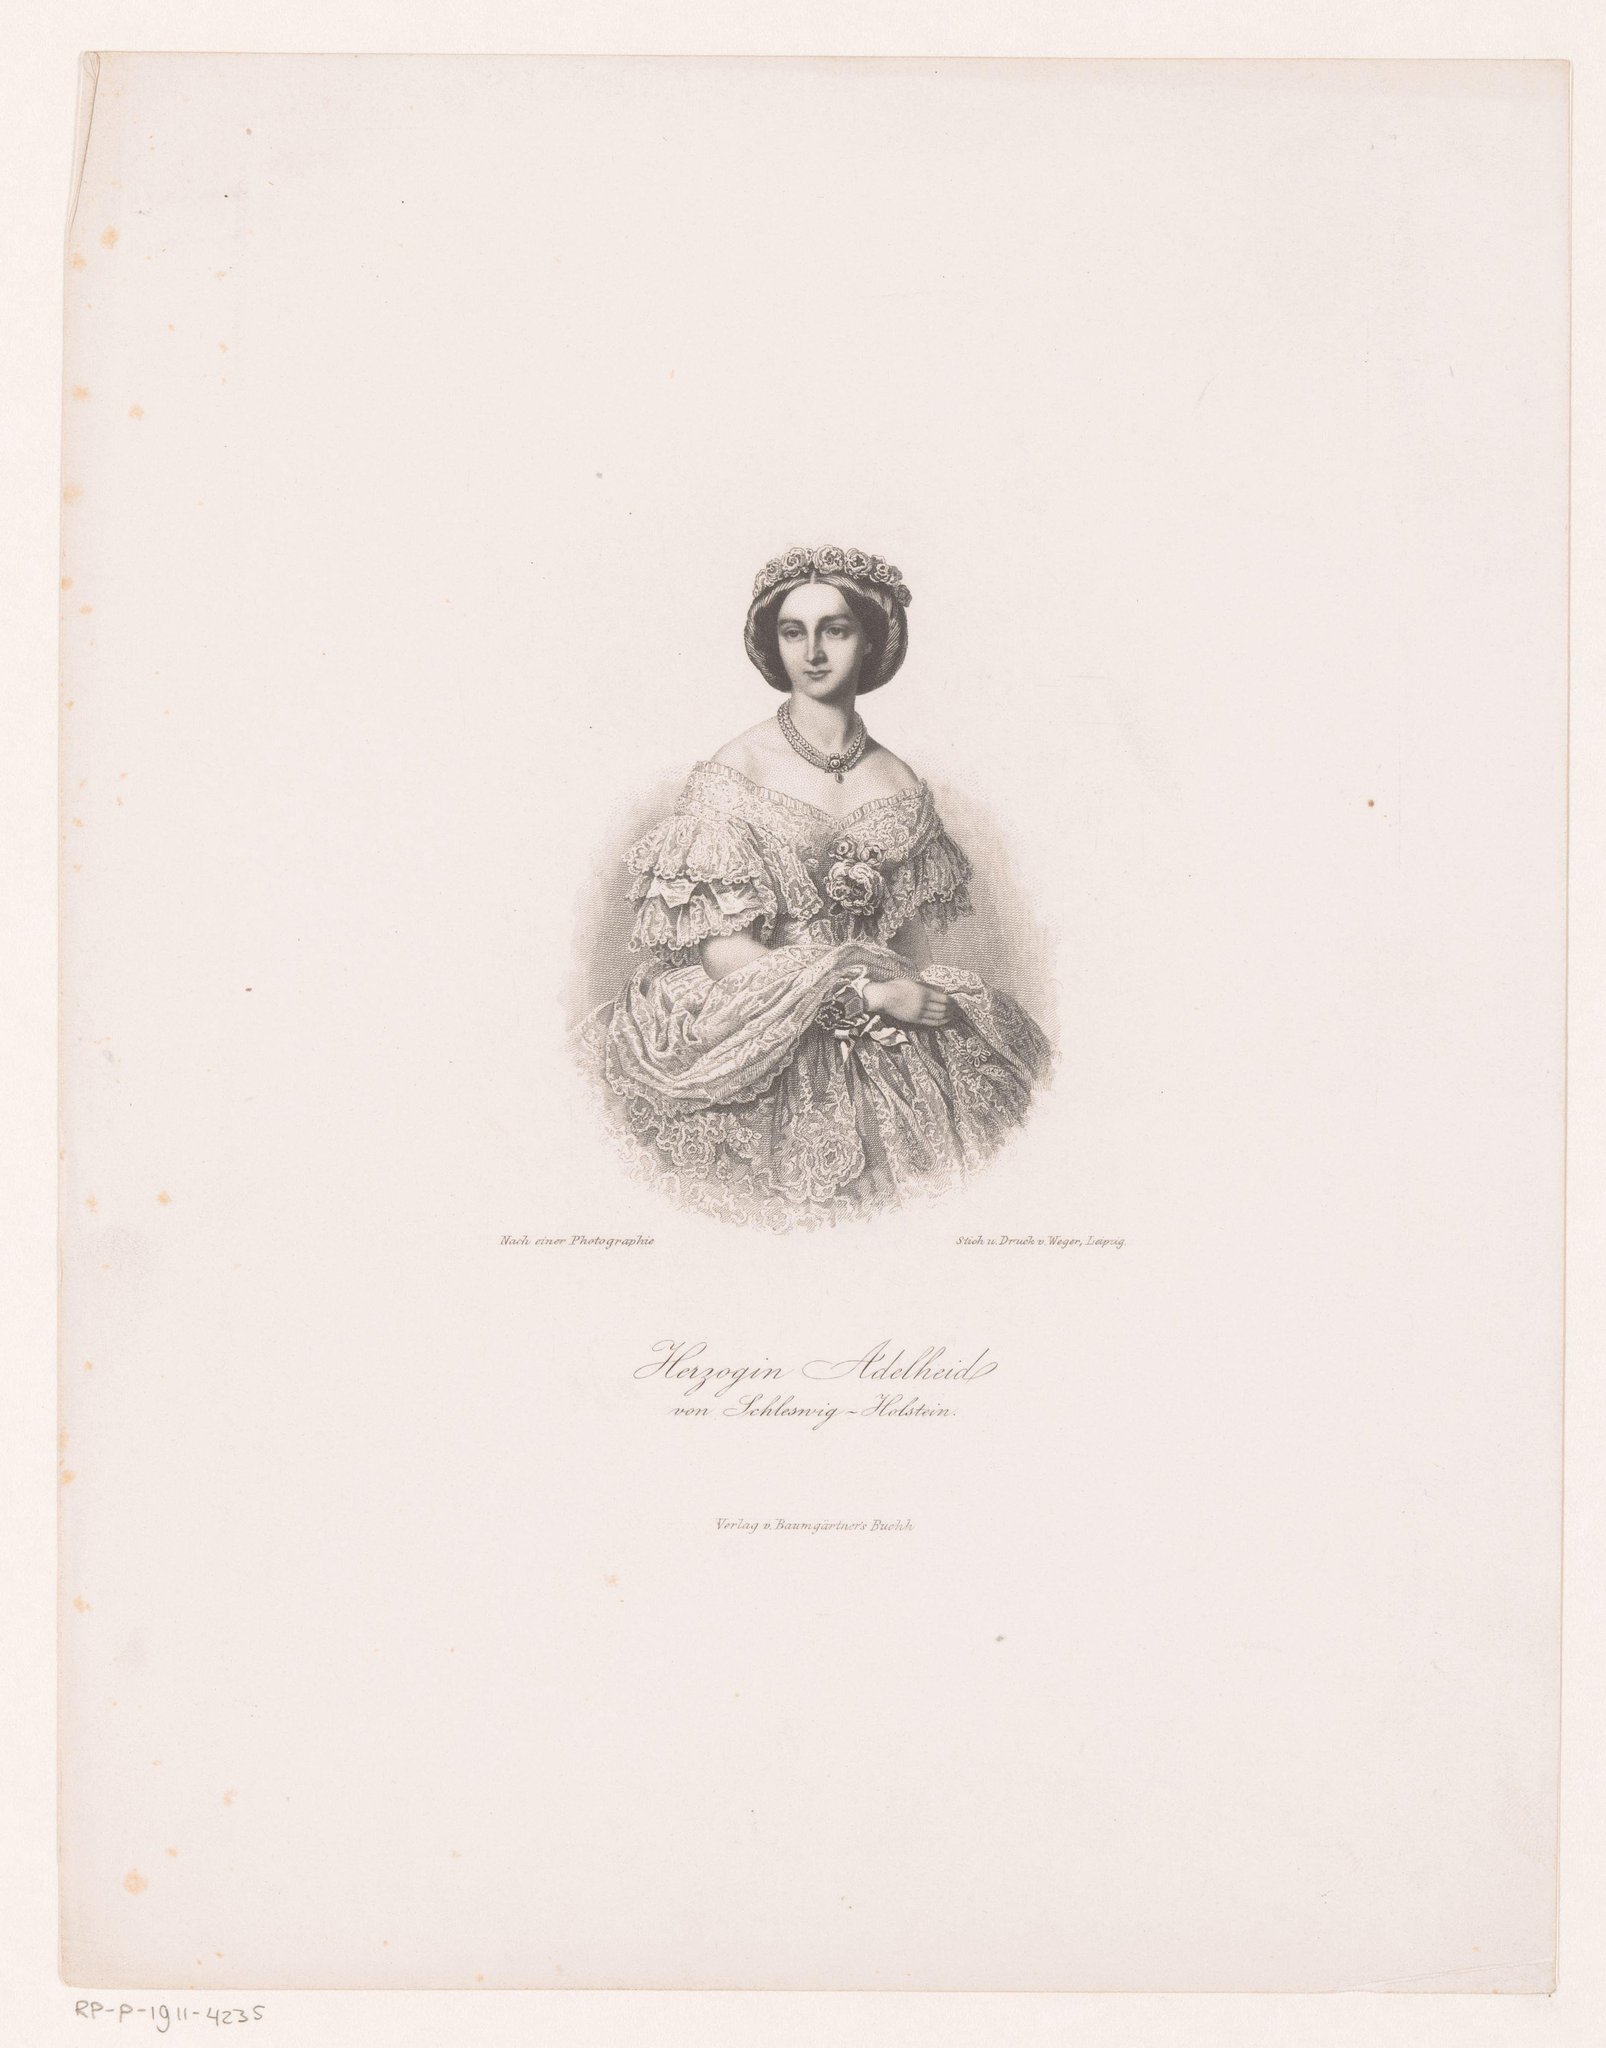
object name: print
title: Portret van Adelheid, prinses van Hohenlohe-Langenburg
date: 1855-1892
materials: paper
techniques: engraving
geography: leipzig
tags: historical persons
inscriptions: collector's mark: Lugt 2228